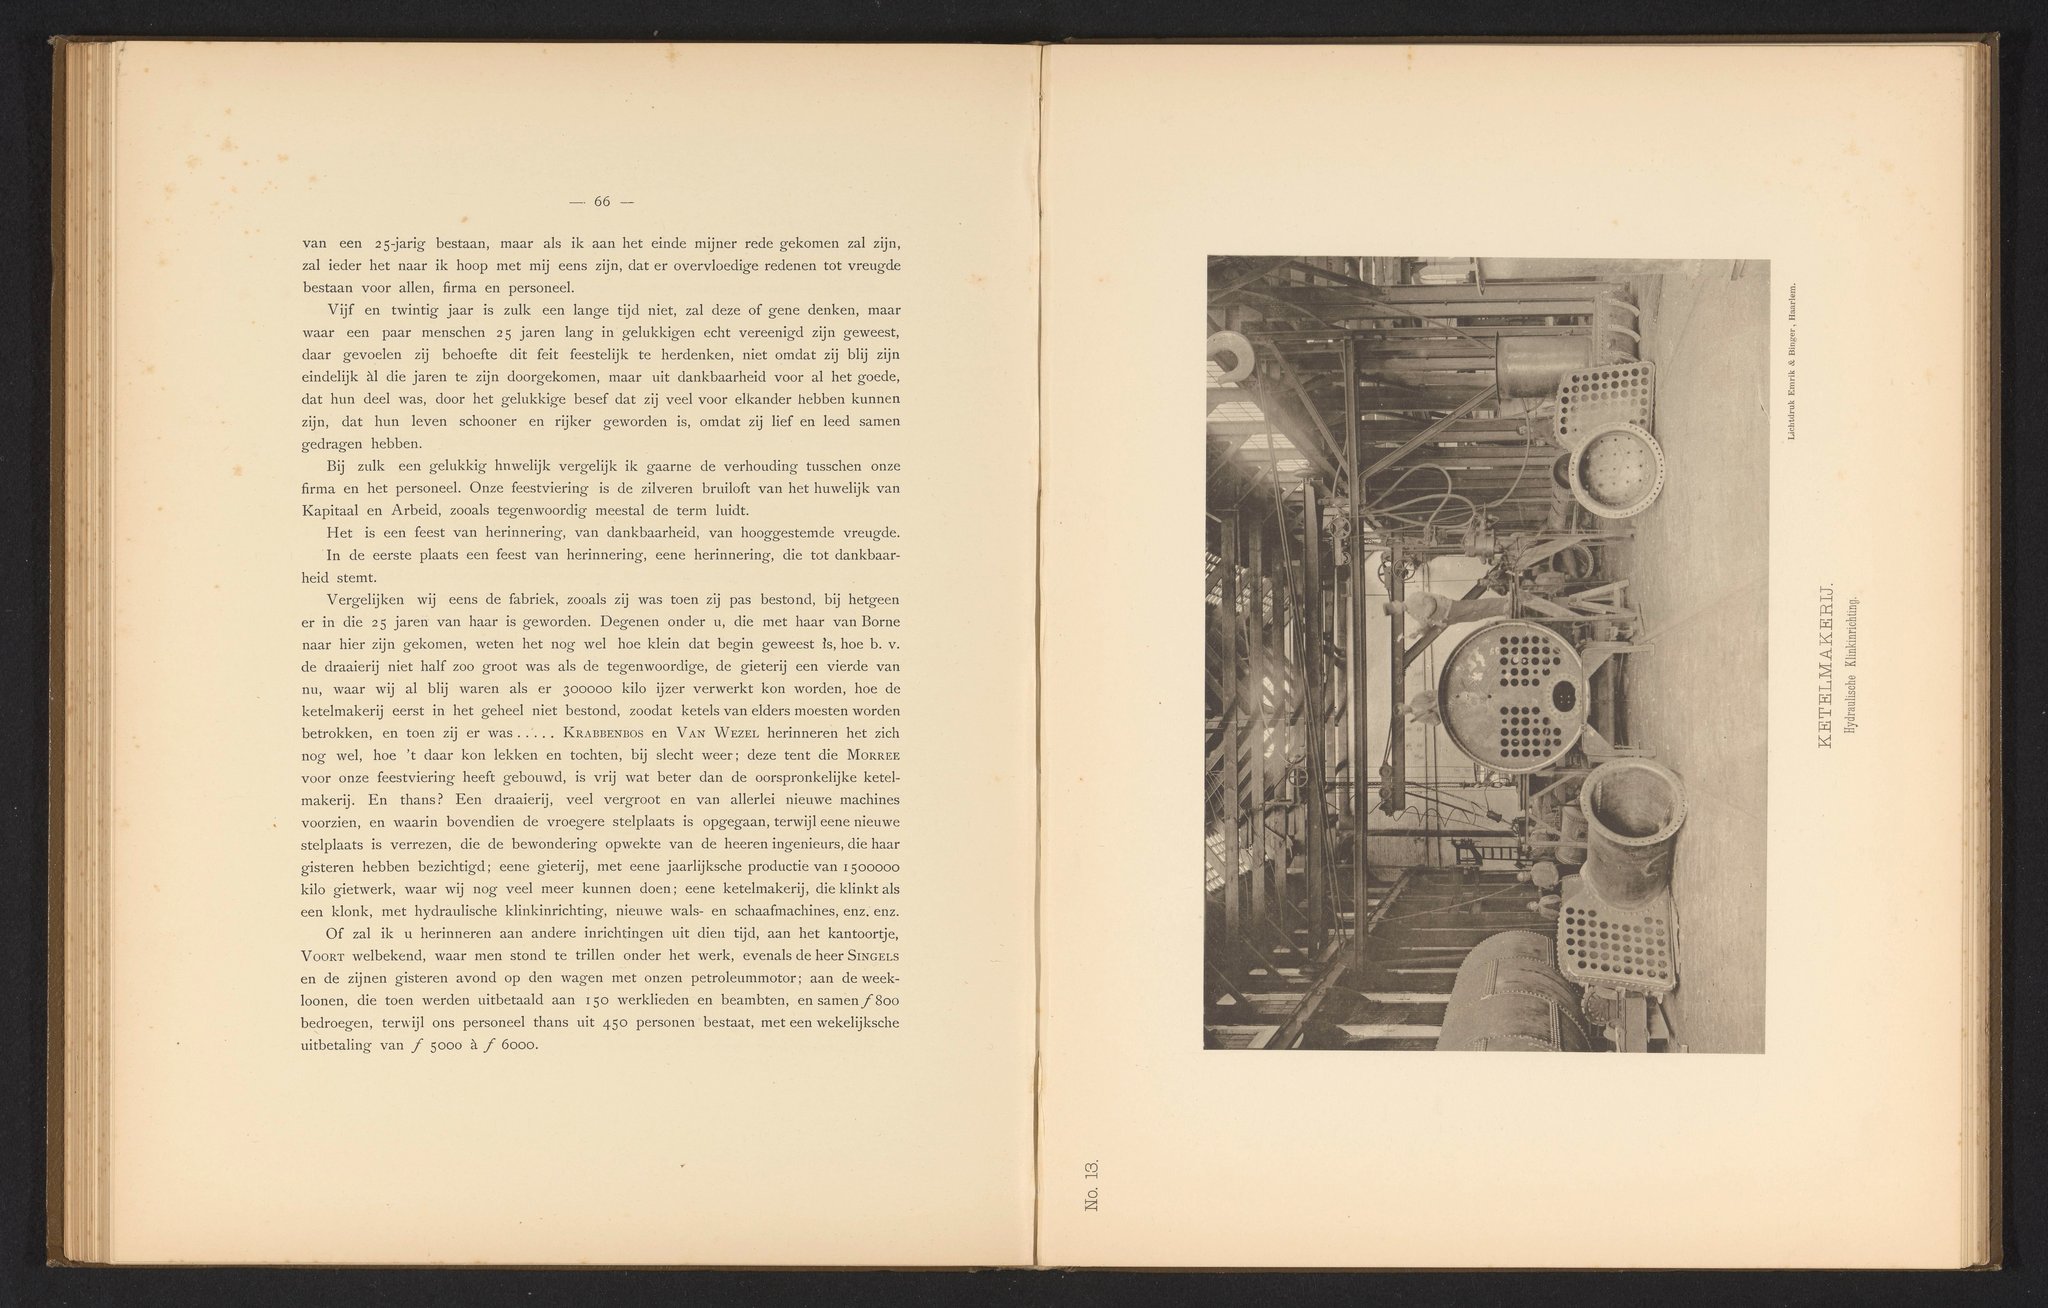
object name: photomechanical print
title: Ketelmakerij. Hydraulische Klinkinrichting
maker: Anonymous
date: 1884-1894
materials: paper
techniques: photograph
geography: hengelo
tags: factory-building, factory-interior, machine shop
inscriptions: number: ‘No. 13.’